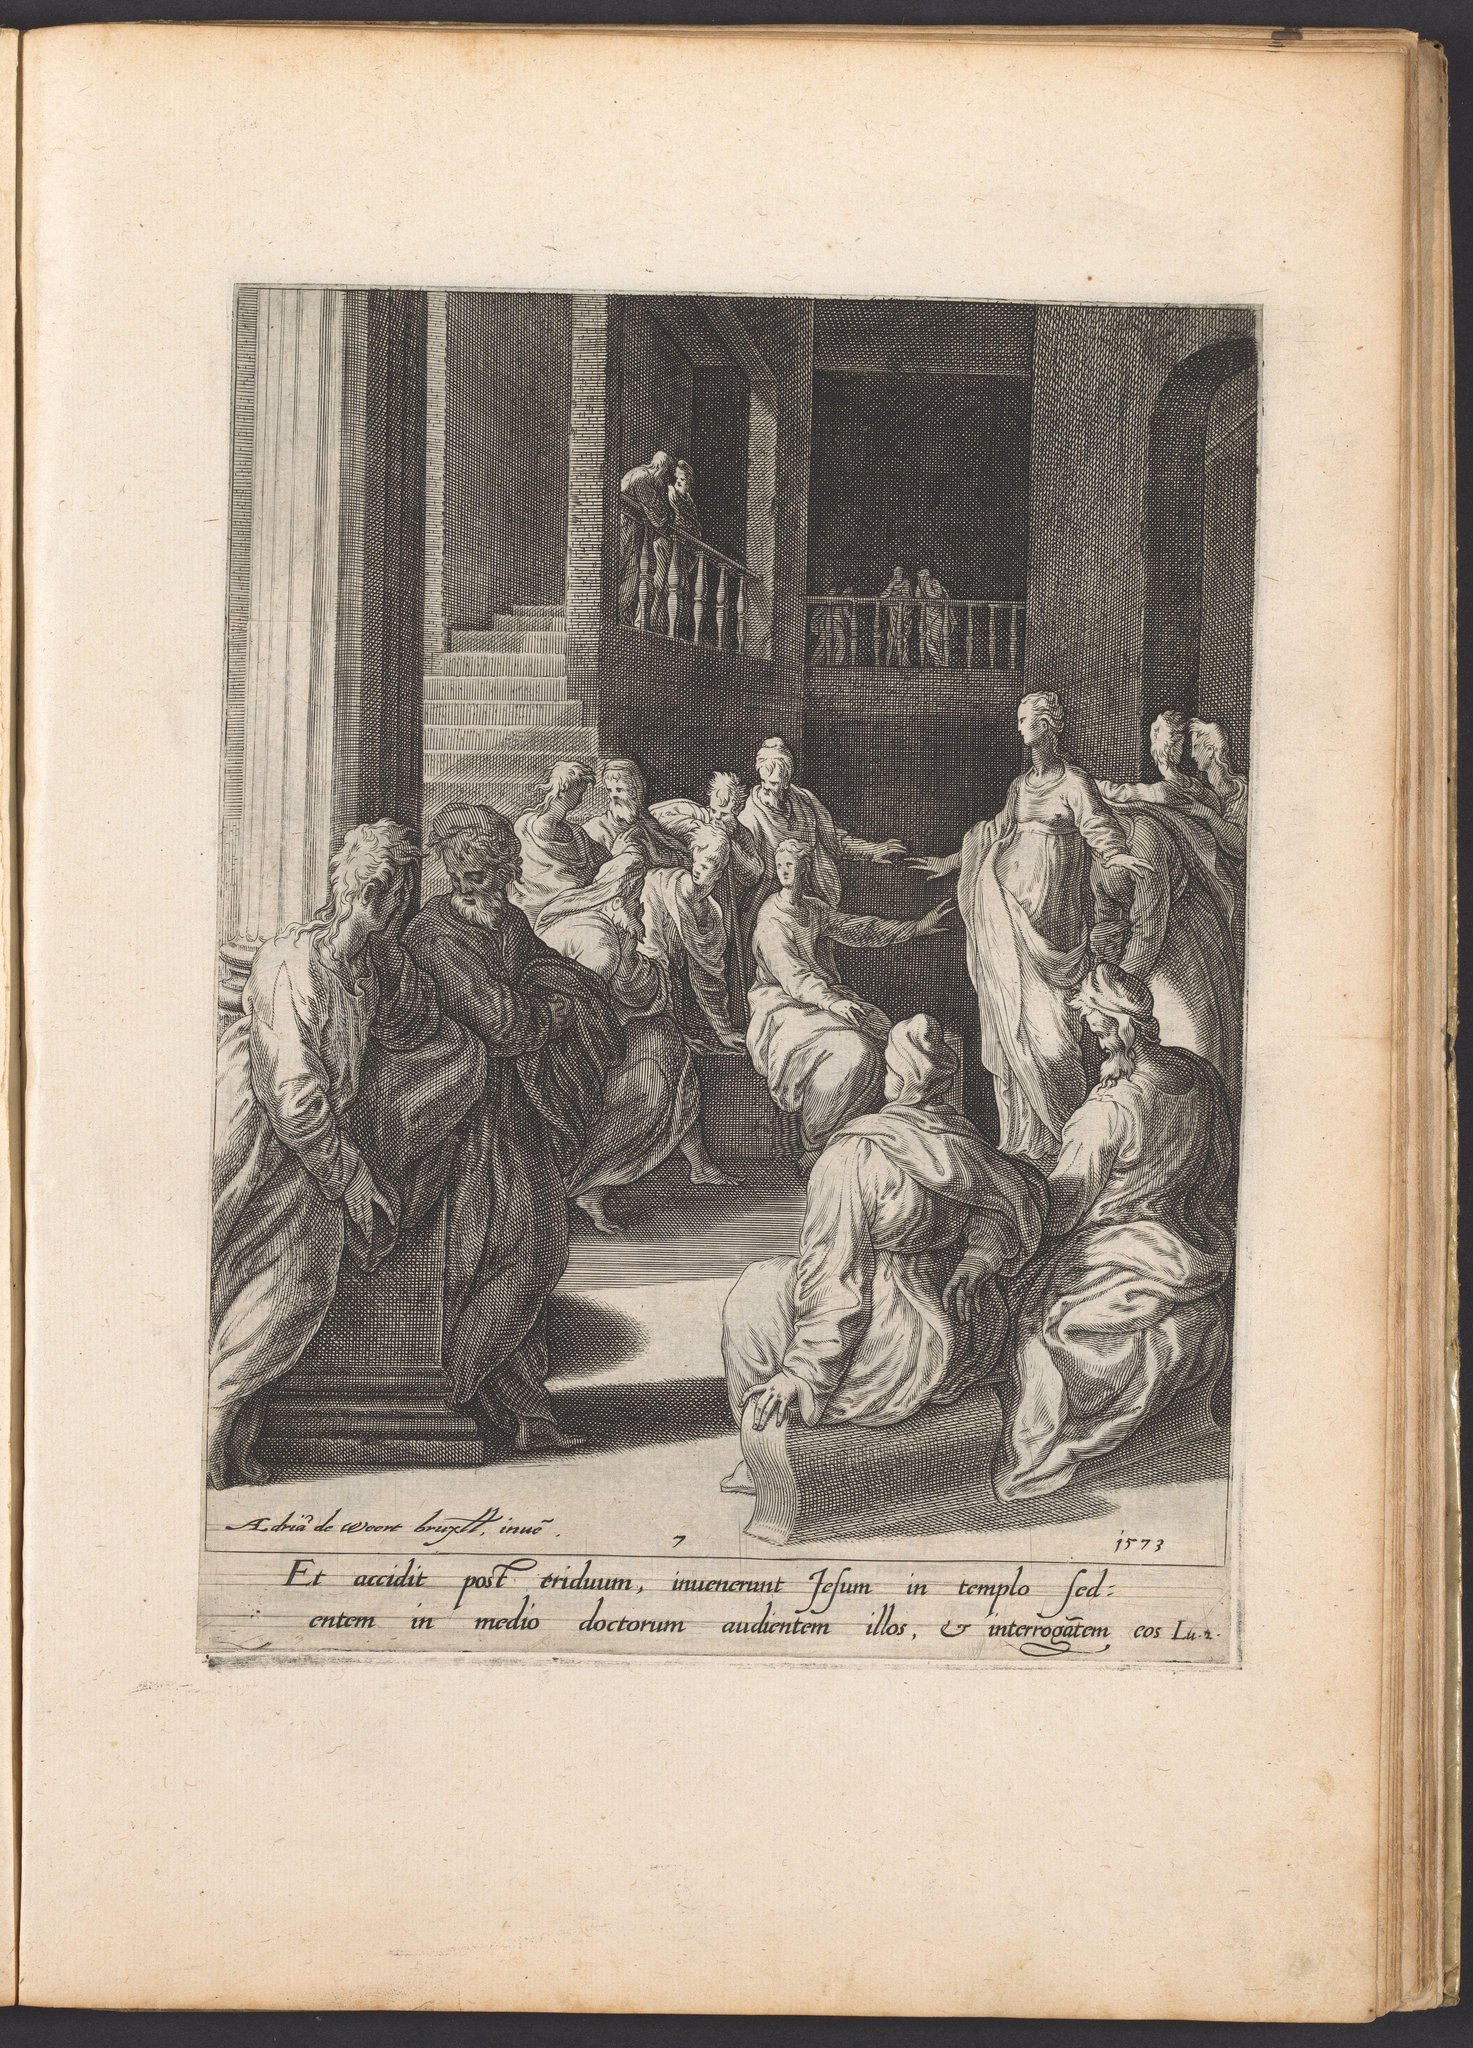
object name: print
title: Scènes uit het leven van Christus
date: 1573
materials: paper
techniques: engraving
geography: brussels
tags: christ's dispute with the doctors in the temple; he counts his arguments on his fingers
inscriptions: date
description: Deze prent maakt deel uit van een album.